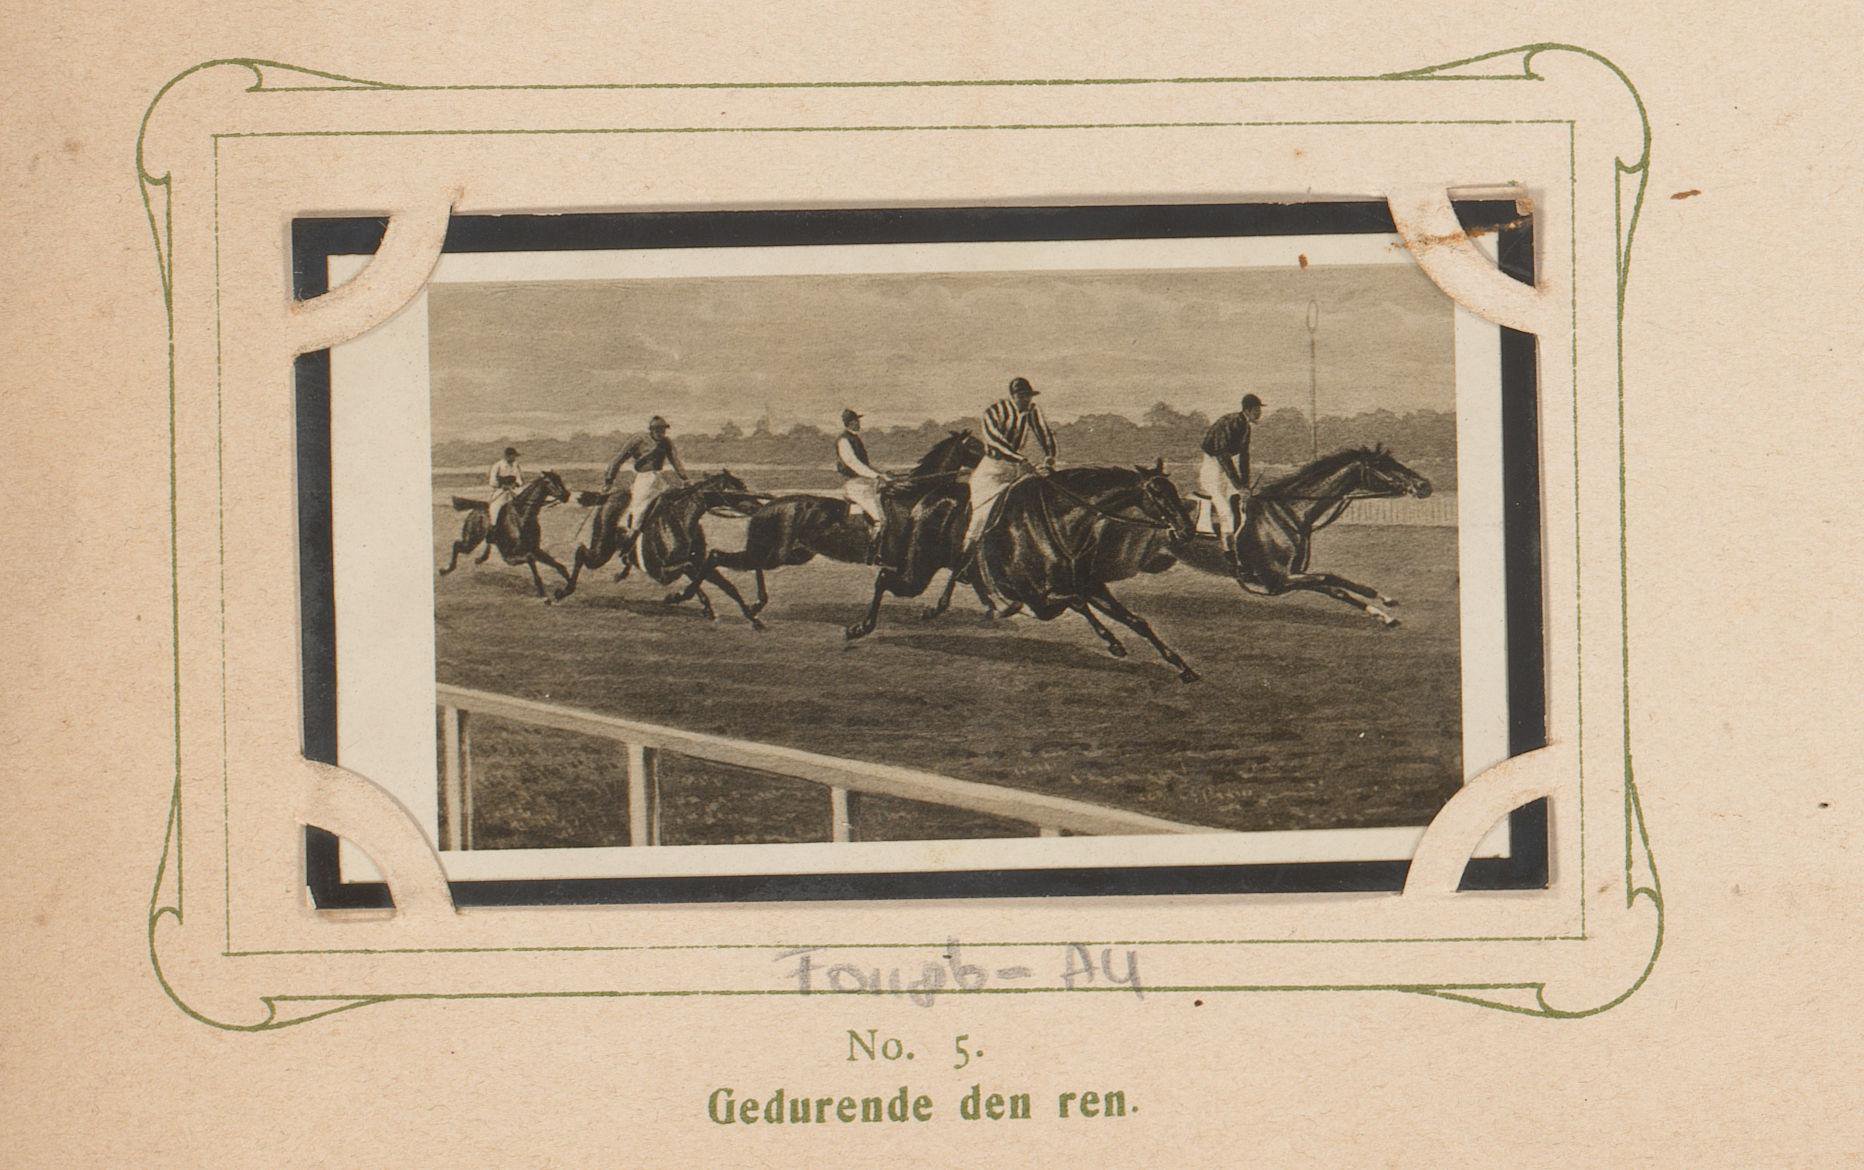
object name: photograph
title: Fotoreproductie van een schilderij van een paardenrace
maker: Anonymous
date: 1904-1905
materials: photographic support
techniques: gelatin silver print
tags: horse-racing, jockey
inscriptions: inscription: ‘No. 5./ Gedurende den ren.’